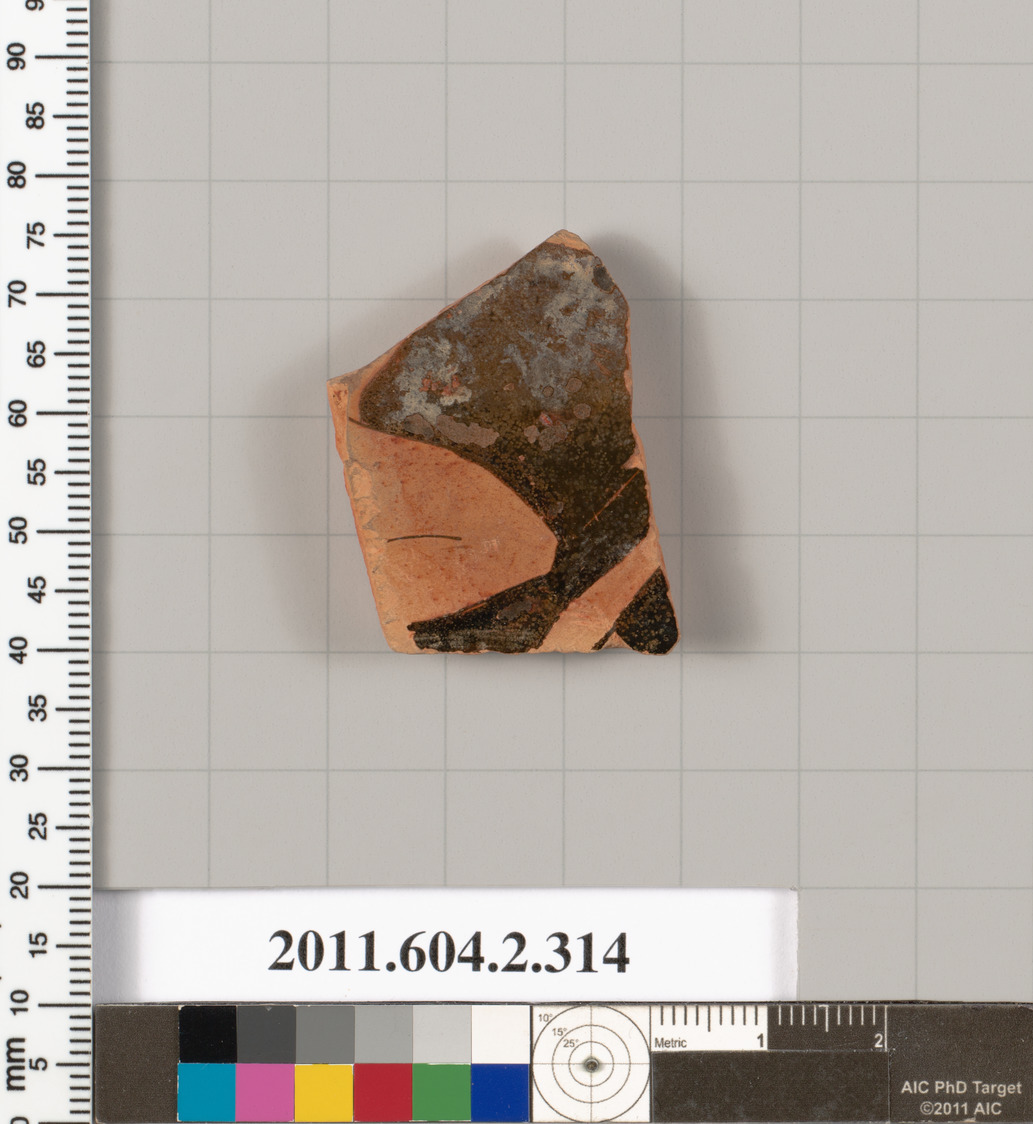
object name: column krater fragment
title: Terracotta fragment of a column-krater (bowl for mixing wine and water)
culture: greek, attic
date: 460-440 BCE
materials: terracotta